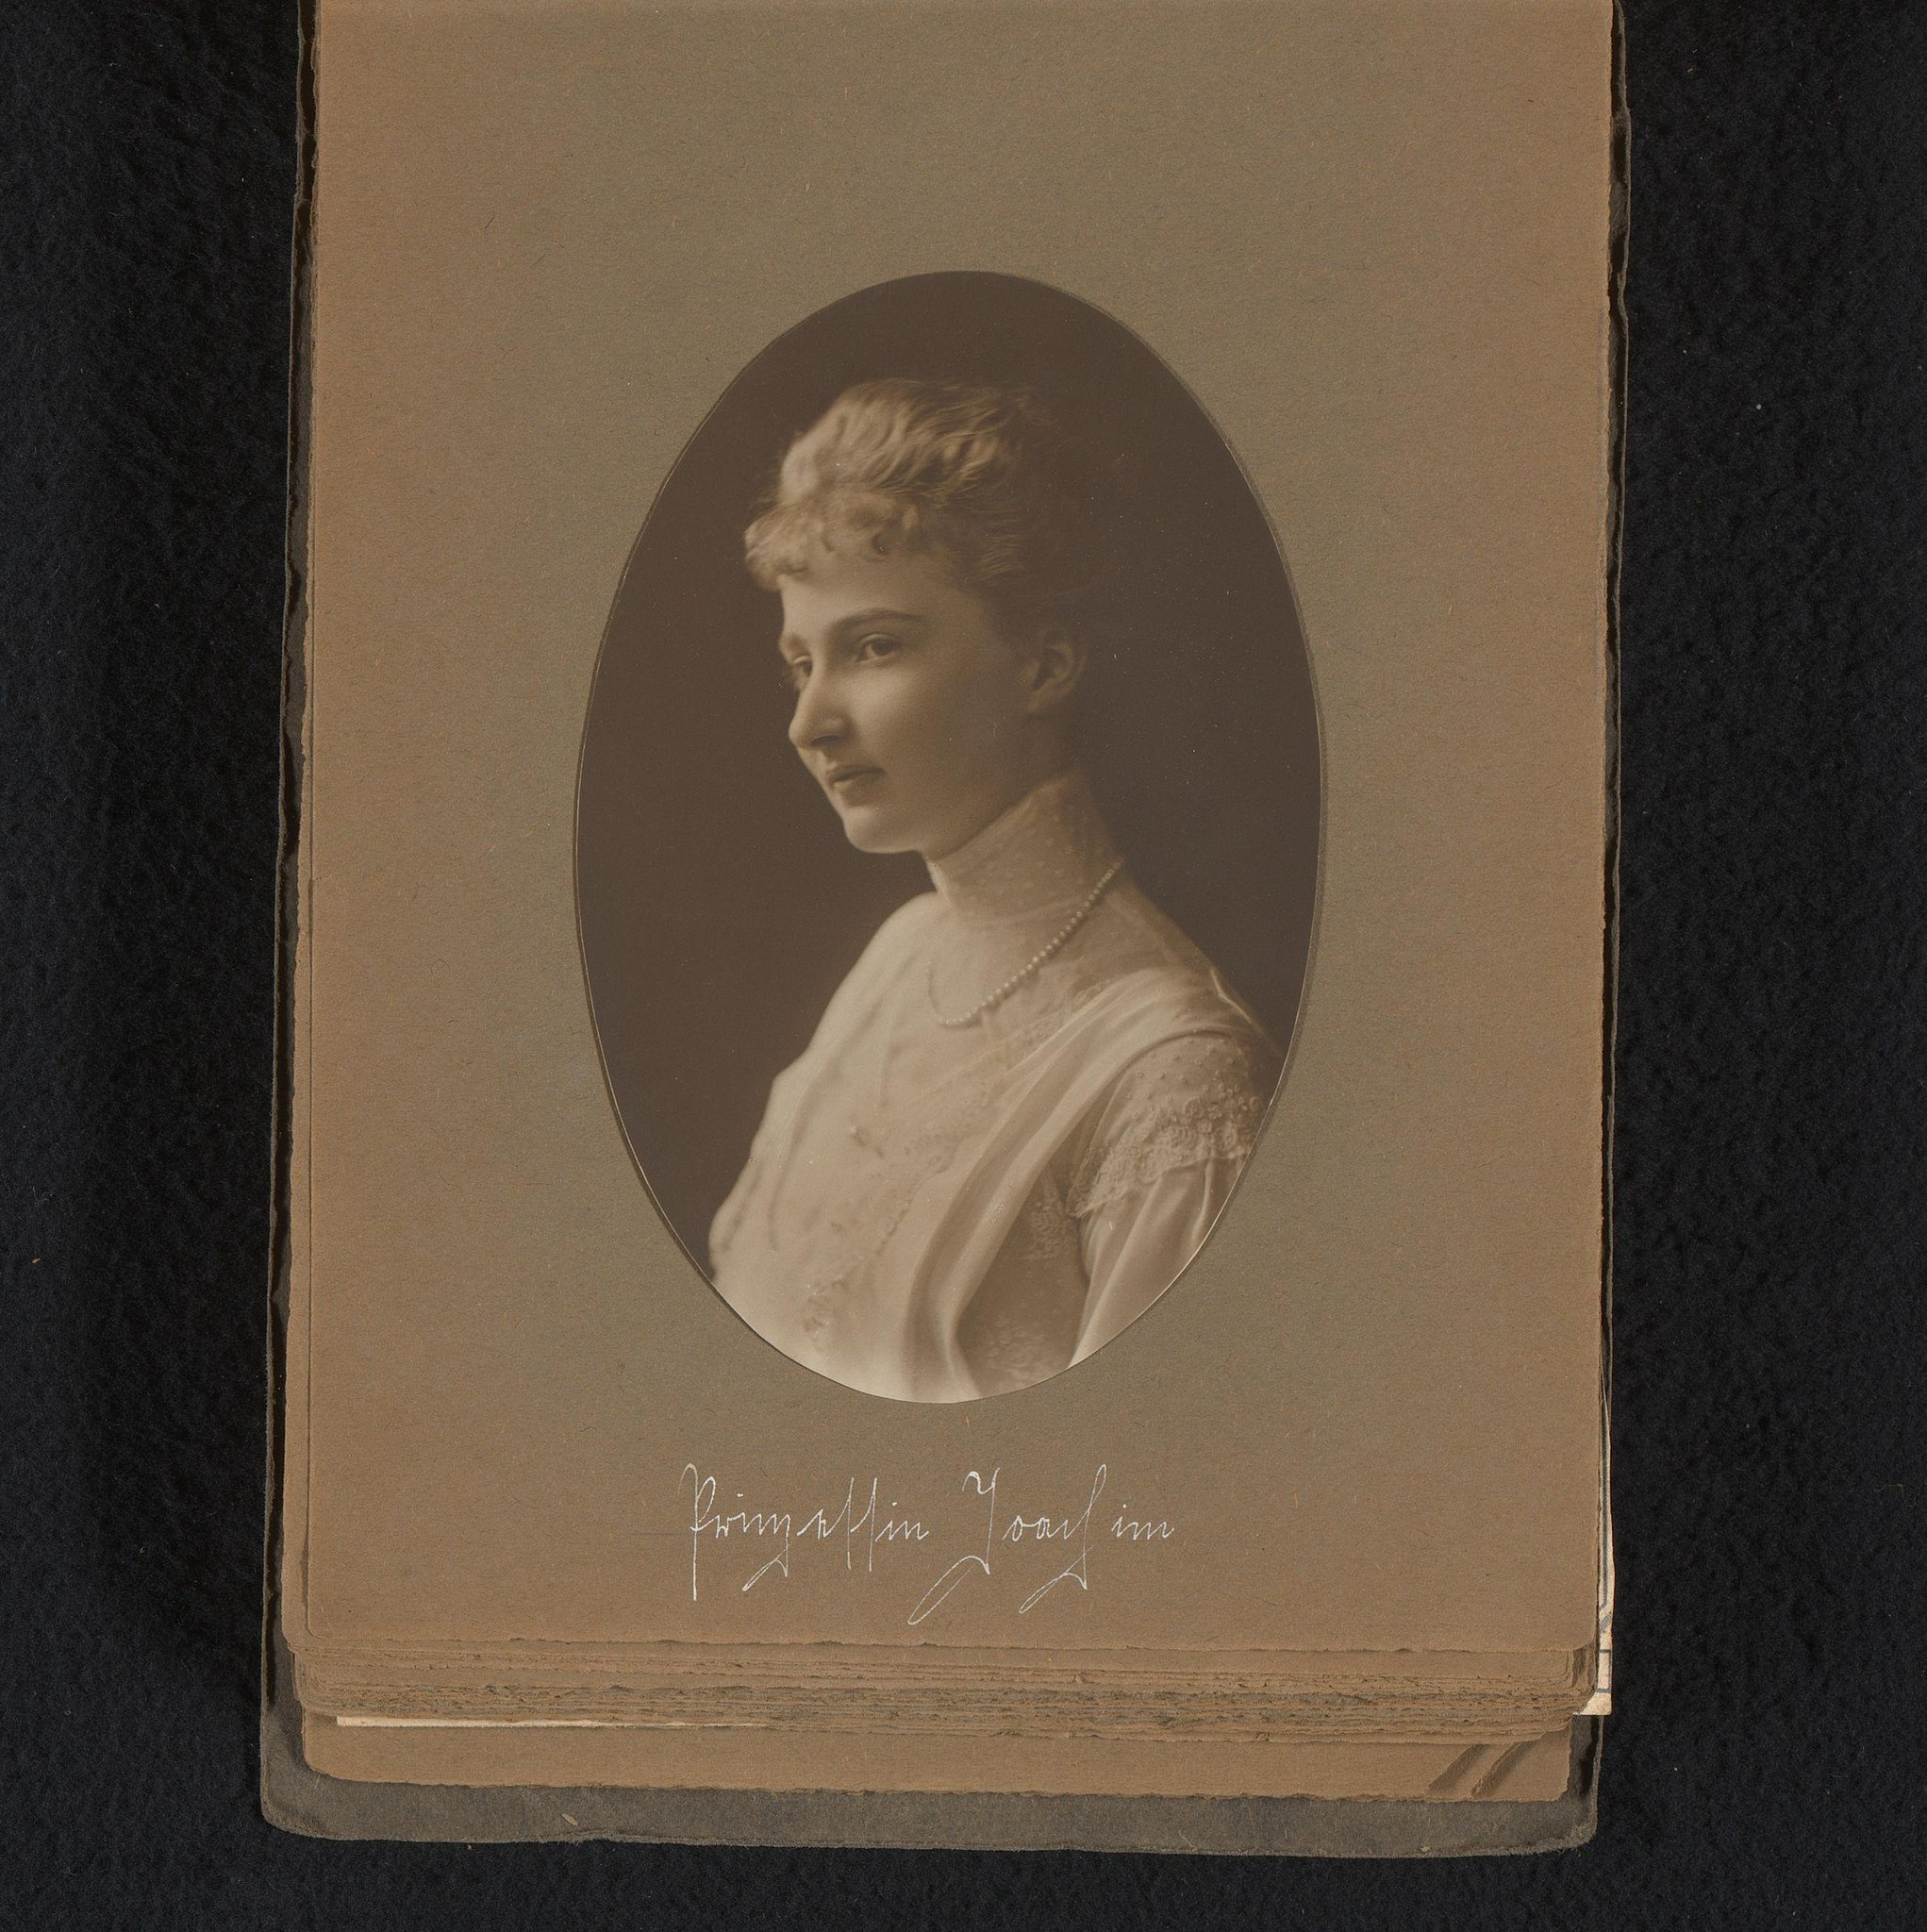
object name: album leaf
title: Portret van Marie Auguste van Anhalt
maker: Anonymous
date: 1916-1921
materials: paper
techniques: gelatin silver print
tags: essen, historical persons, princess